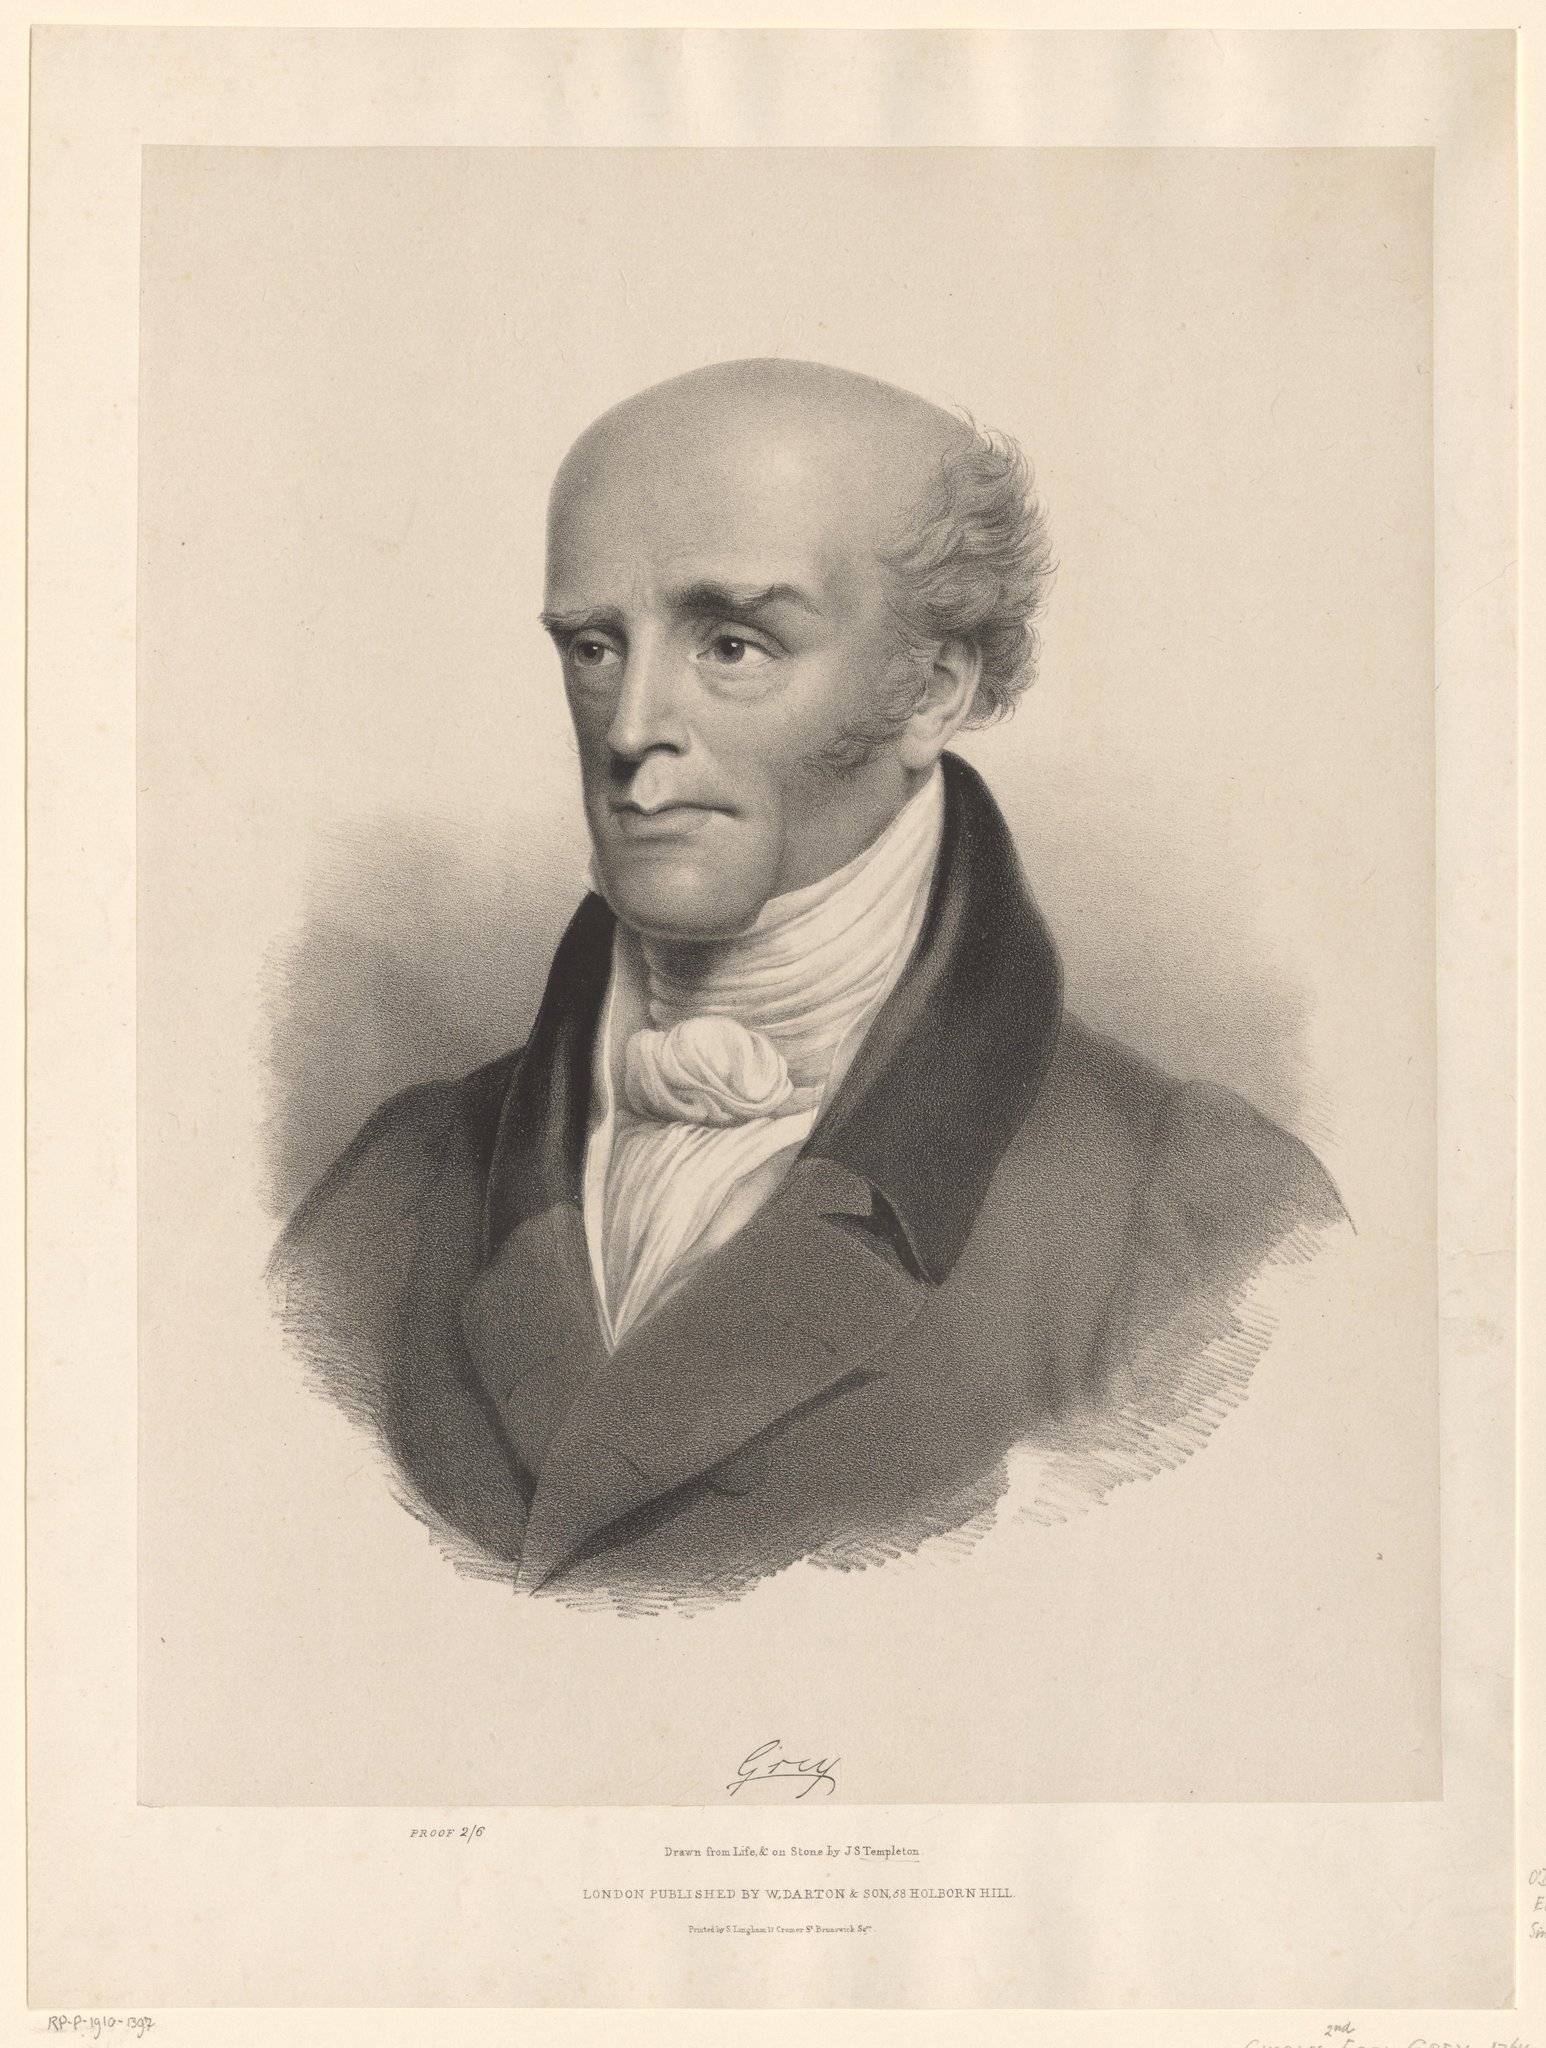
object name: print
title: Portret van Charles Grey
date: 1834-1866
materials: paper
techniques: lithograph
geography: london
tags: historical persons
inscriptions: collector's mark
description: Onder het portret een facsimile van de handtekening van de geportretteerde.